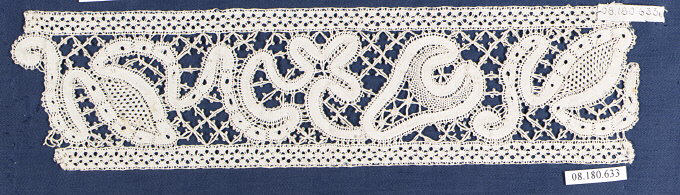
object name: insertion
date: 1801-1900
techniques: lace